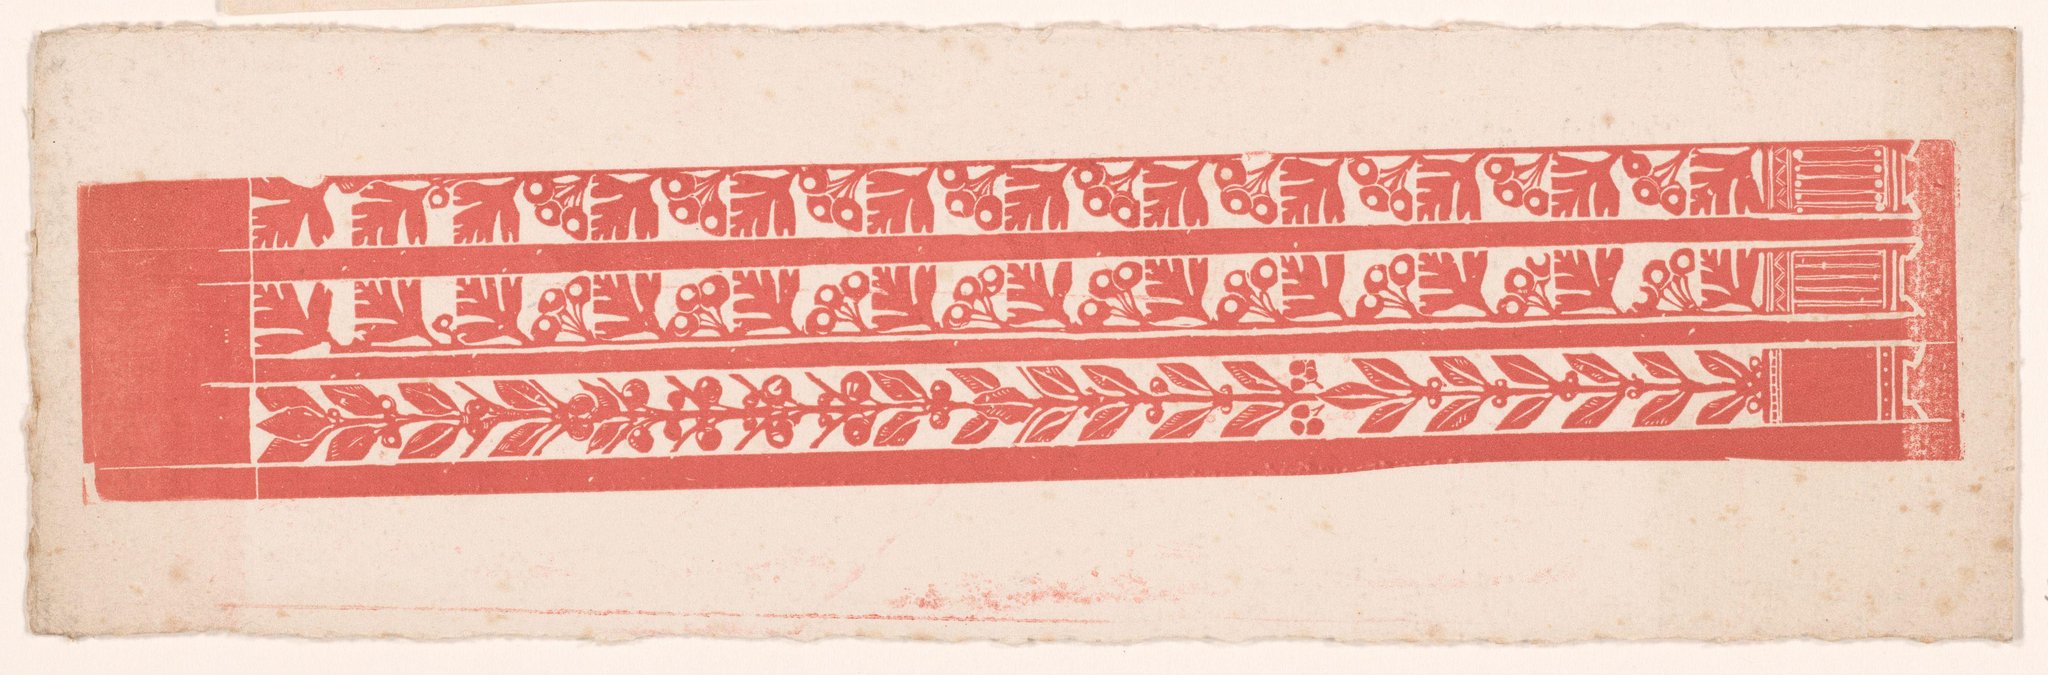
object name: boekillustratie ontwerp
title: Ornamenten met planten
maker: bernard willem wierink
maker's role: draughtsman, print maker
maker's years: 1856-1939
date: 1910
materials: paper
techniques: relief print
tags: ornaments ~ art, fable of reynard the fox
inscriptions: collector's mark: Lugt 2228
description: Ontwerp voor: Streuvels, Stijn (Frank Lateur). Reinaert de Vos naar verschillende uitgaven van het middeleeuwsche epos. Amsterdam: L.J. Veen, 1910. Deze prent is vermoedelijk een plaatsnede, ook al wordt in de literatuur veelal gesproken over een houtsnede. Voor zover Wierink zijn prenten in hoogdruk zelf nader heeft omschreven, heeft hij altijd de term 'plaatsnede' gebruikt.